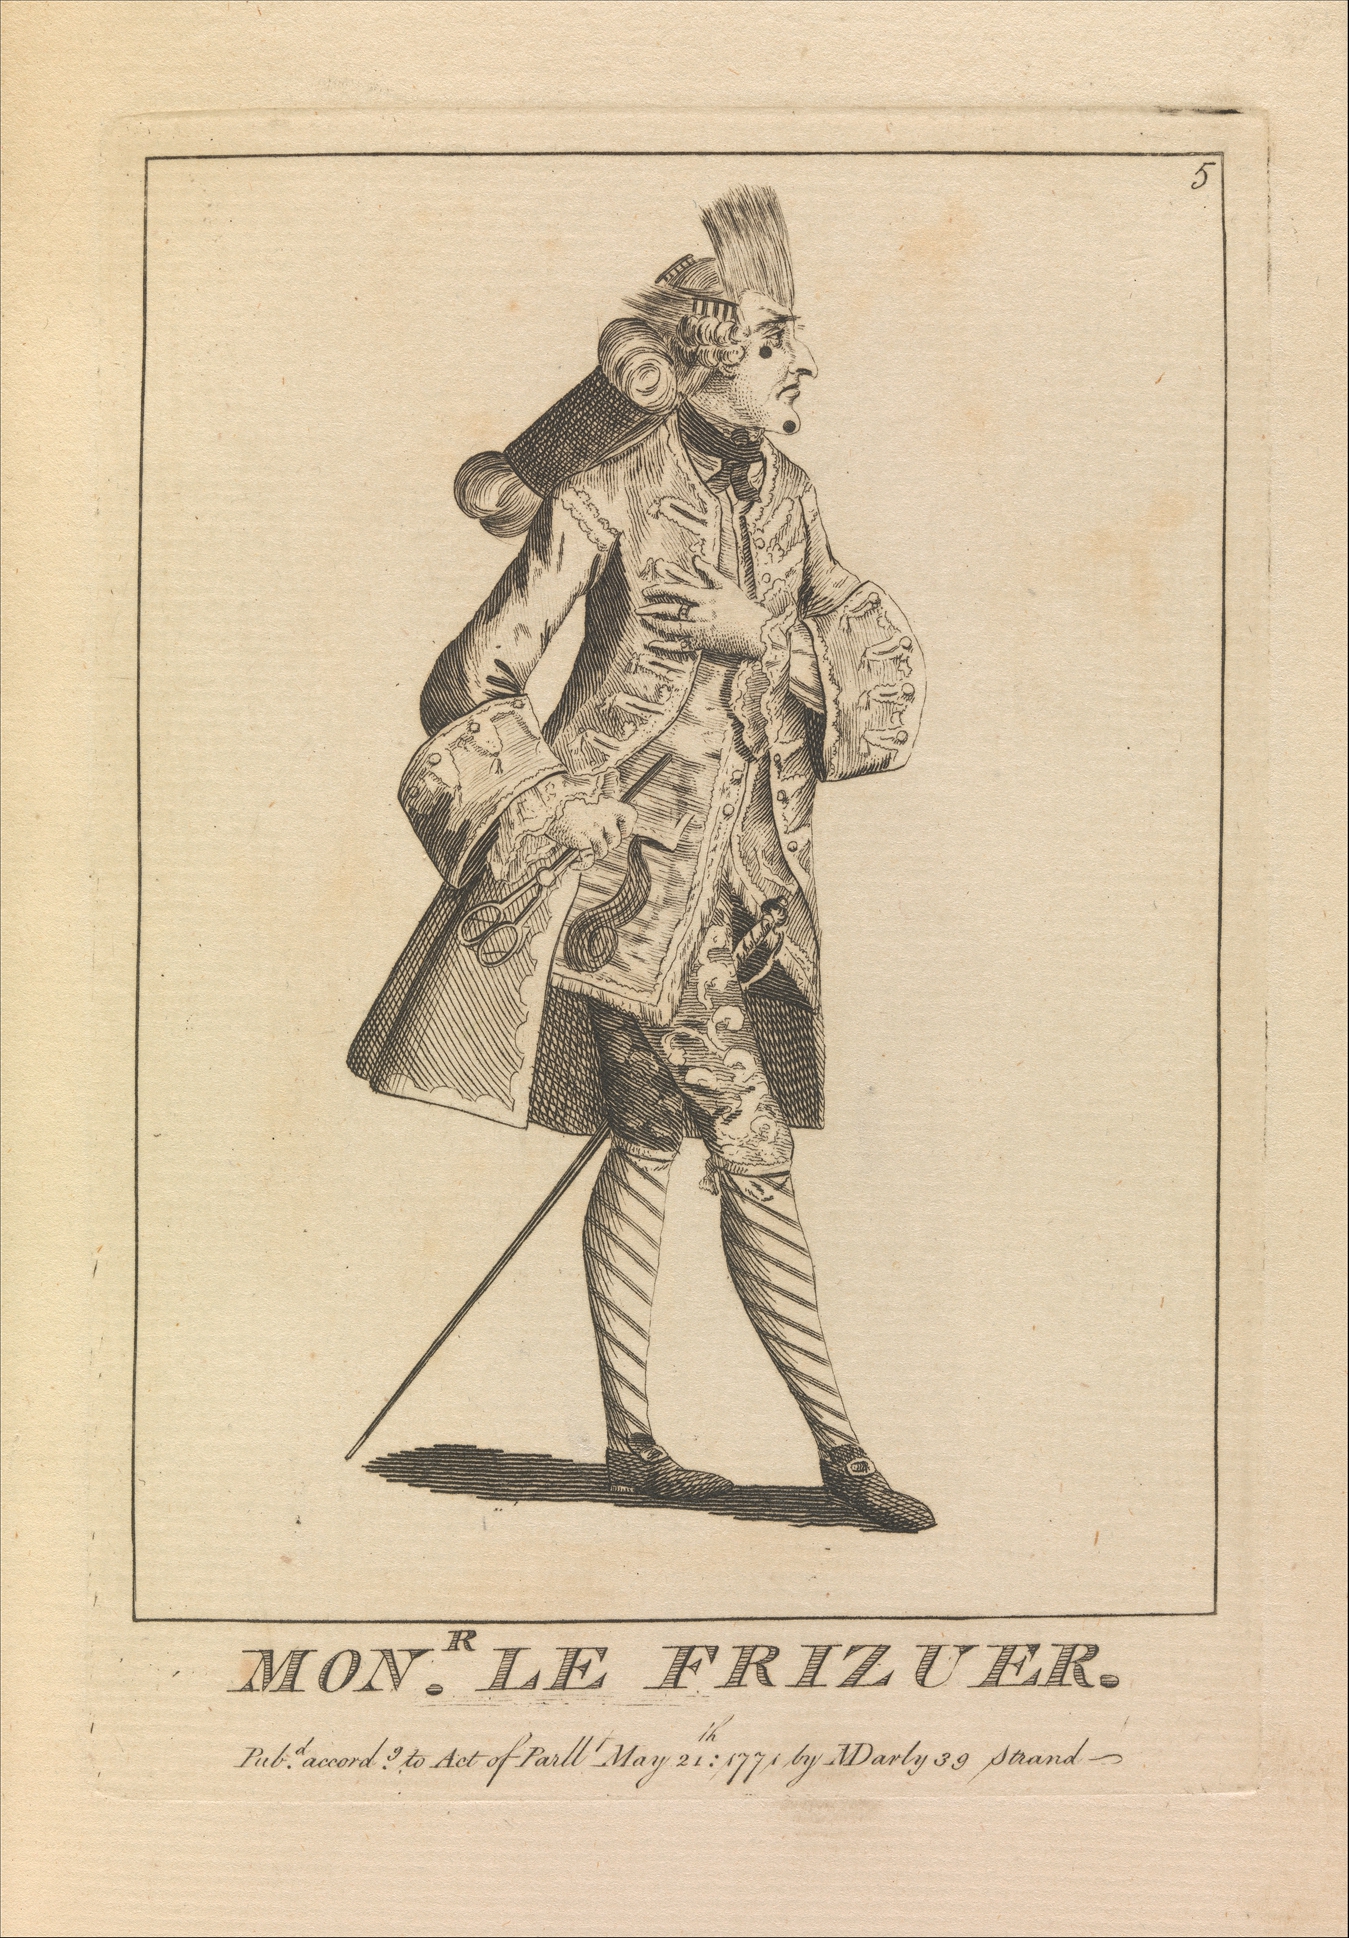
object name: print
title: Monsieur Le Frizeur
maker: henry william bunbury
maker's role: artist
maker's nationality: british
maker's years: 1750-1811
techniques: etching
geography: london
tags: men